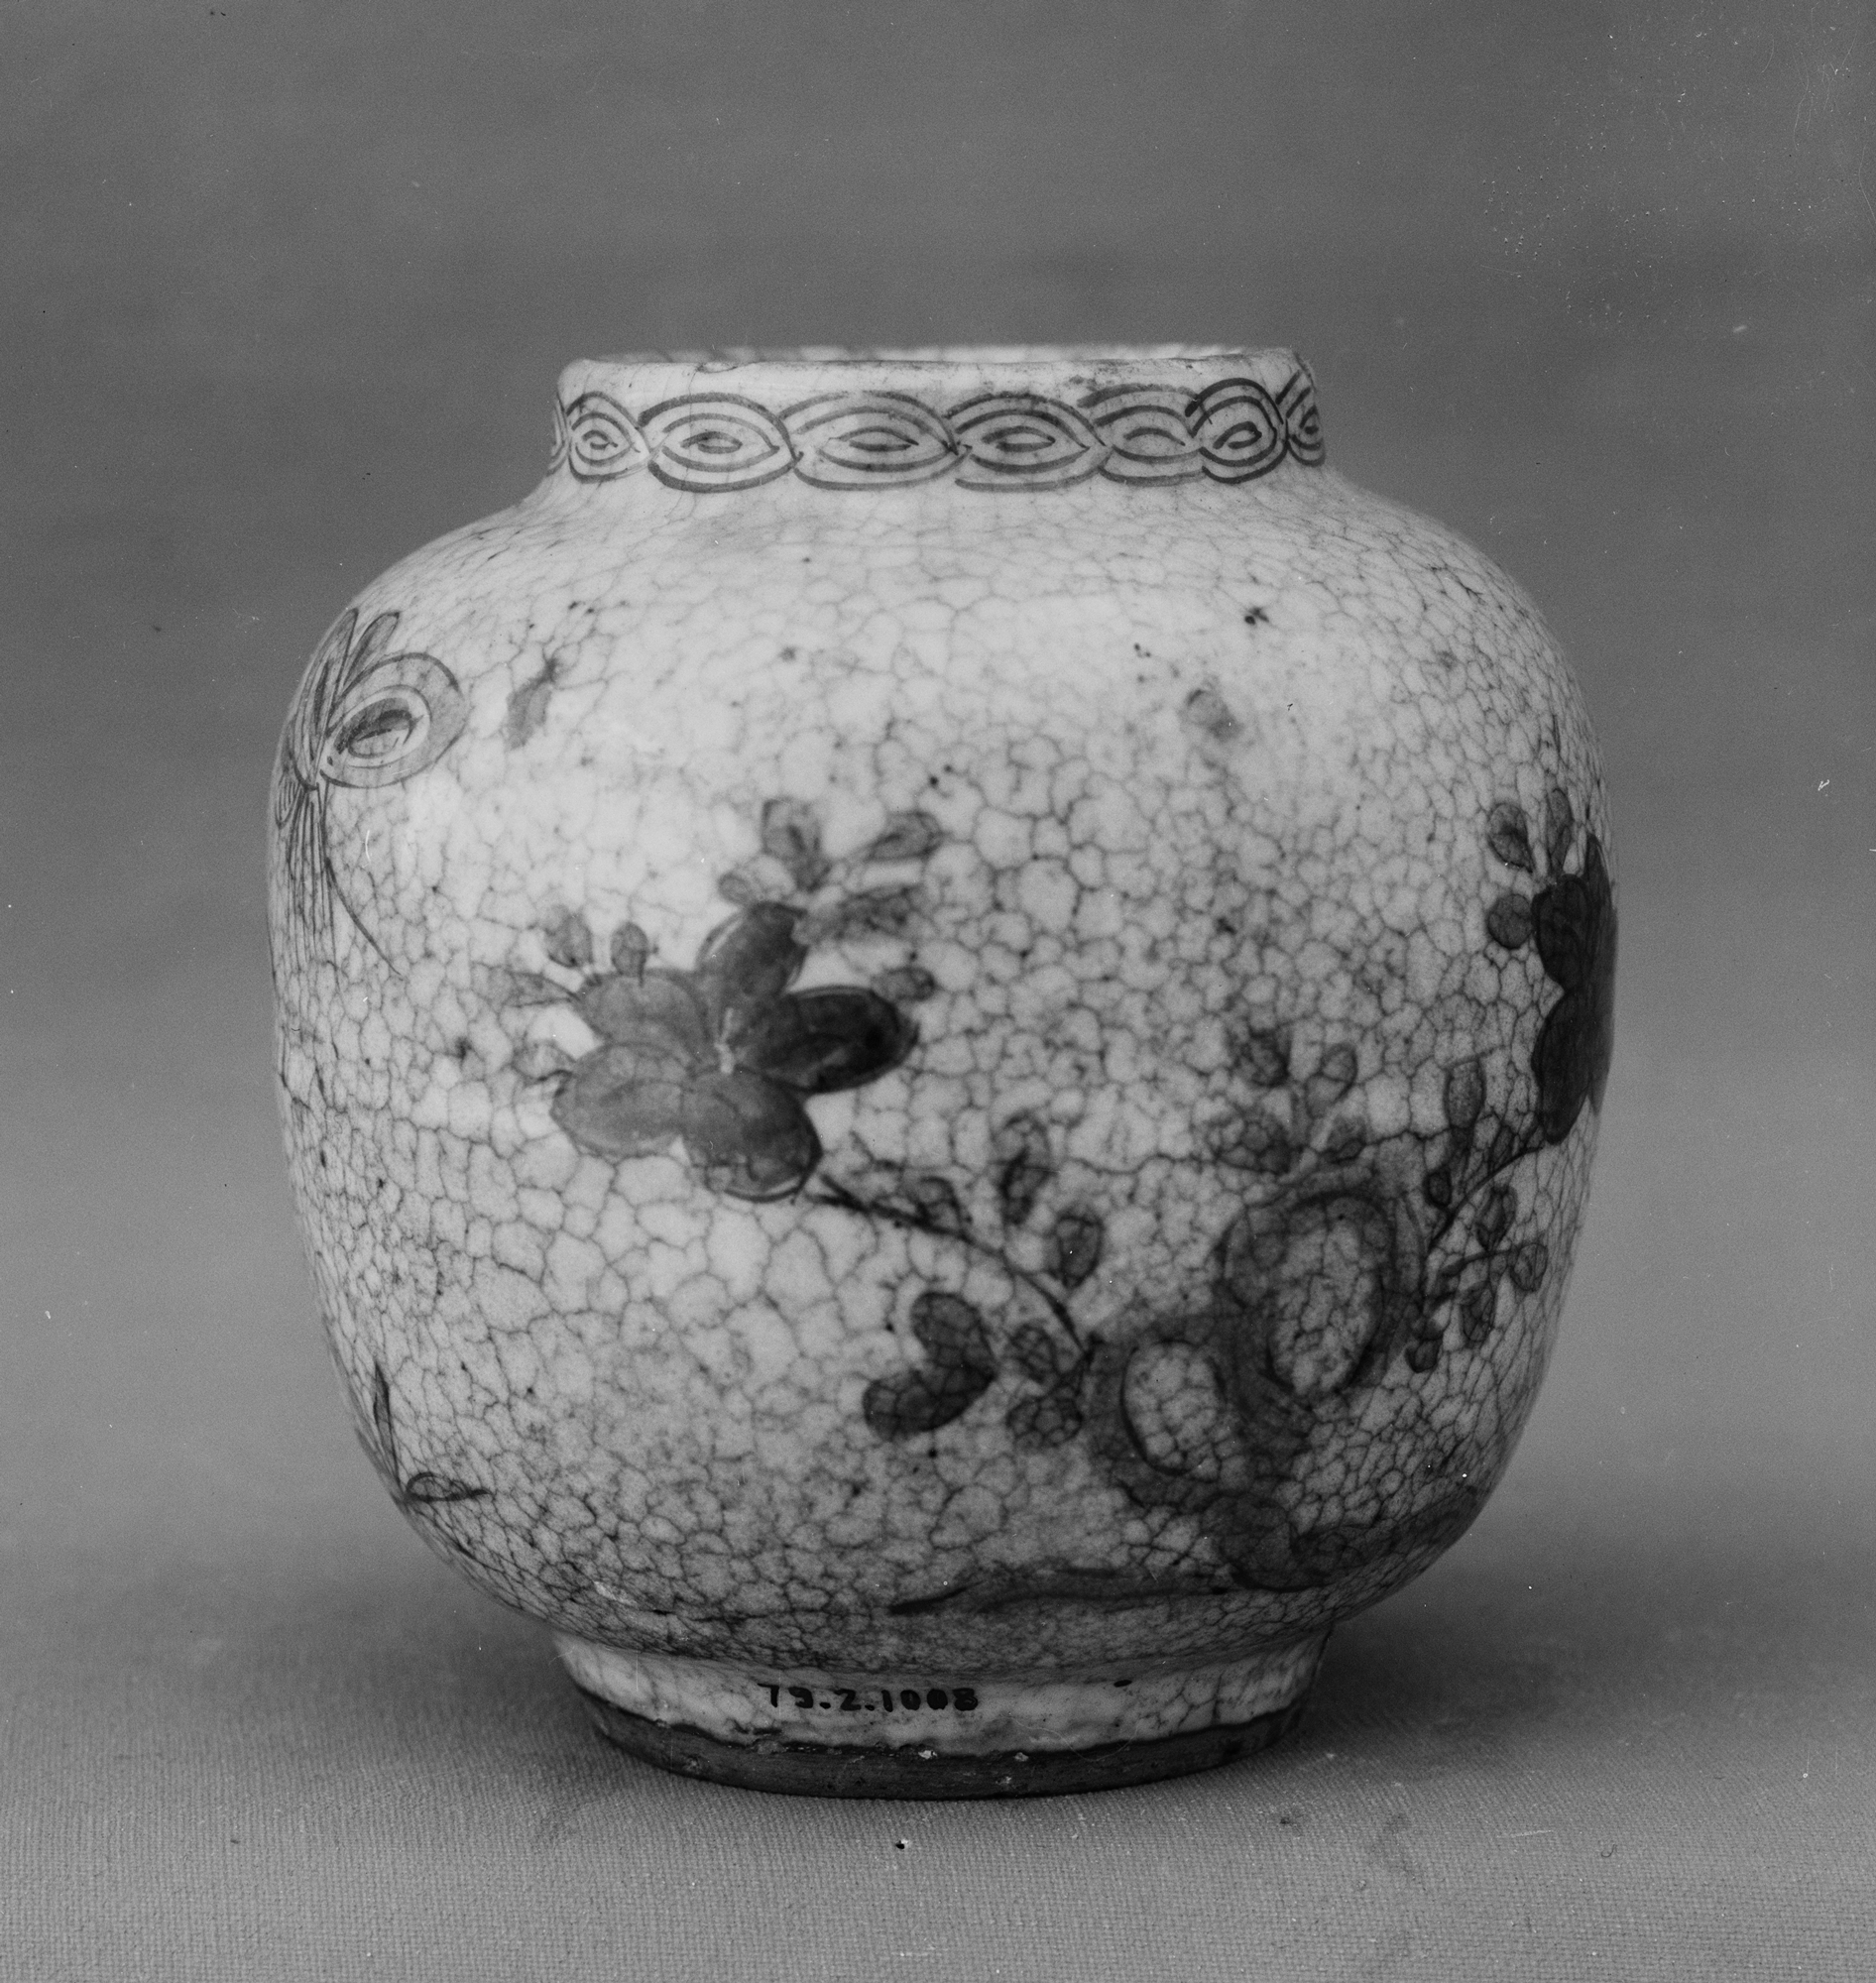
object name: jar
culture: japanese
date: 1701-1800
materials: clay, enamel, glaze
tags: flowers